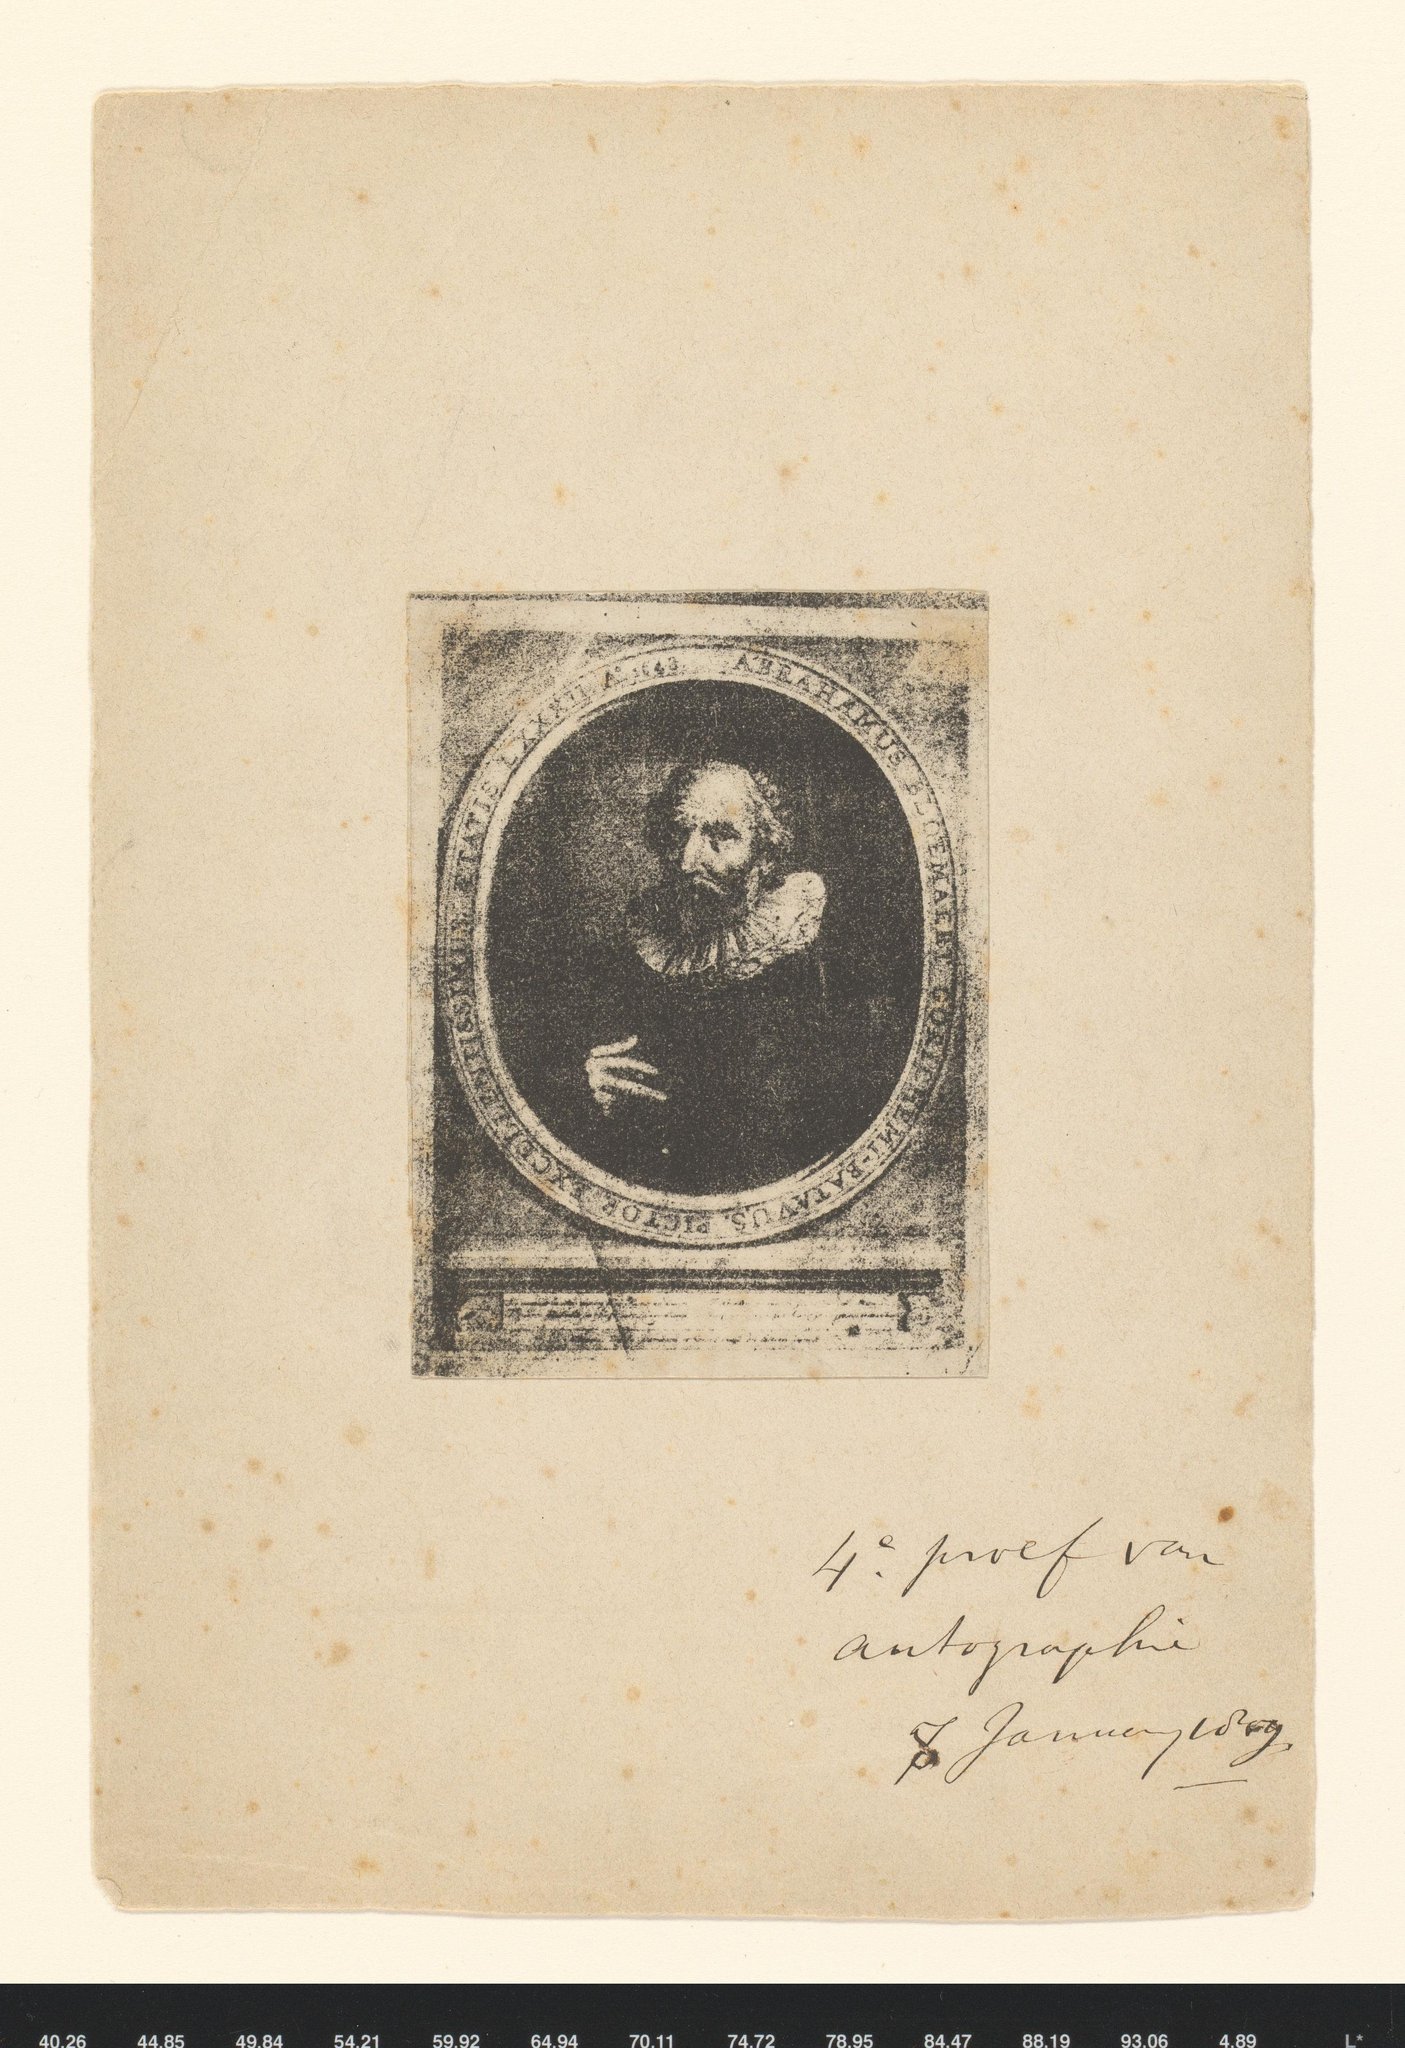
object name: reproduction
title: Reproductie van een portret van Abraham Bloemaert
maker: eduard isaac asser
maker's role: amateurfotograaf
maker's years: 1809-1894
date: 1859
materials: paper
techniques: photolithograph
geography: amsterdam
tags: utrecht, painter, print maker, draughtsman, abraham bloemaert, adult man, historical persons, artist (in general), amsterdam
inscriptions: annotation: ‘4e proef van/ autographi/ 8 January 1859.’